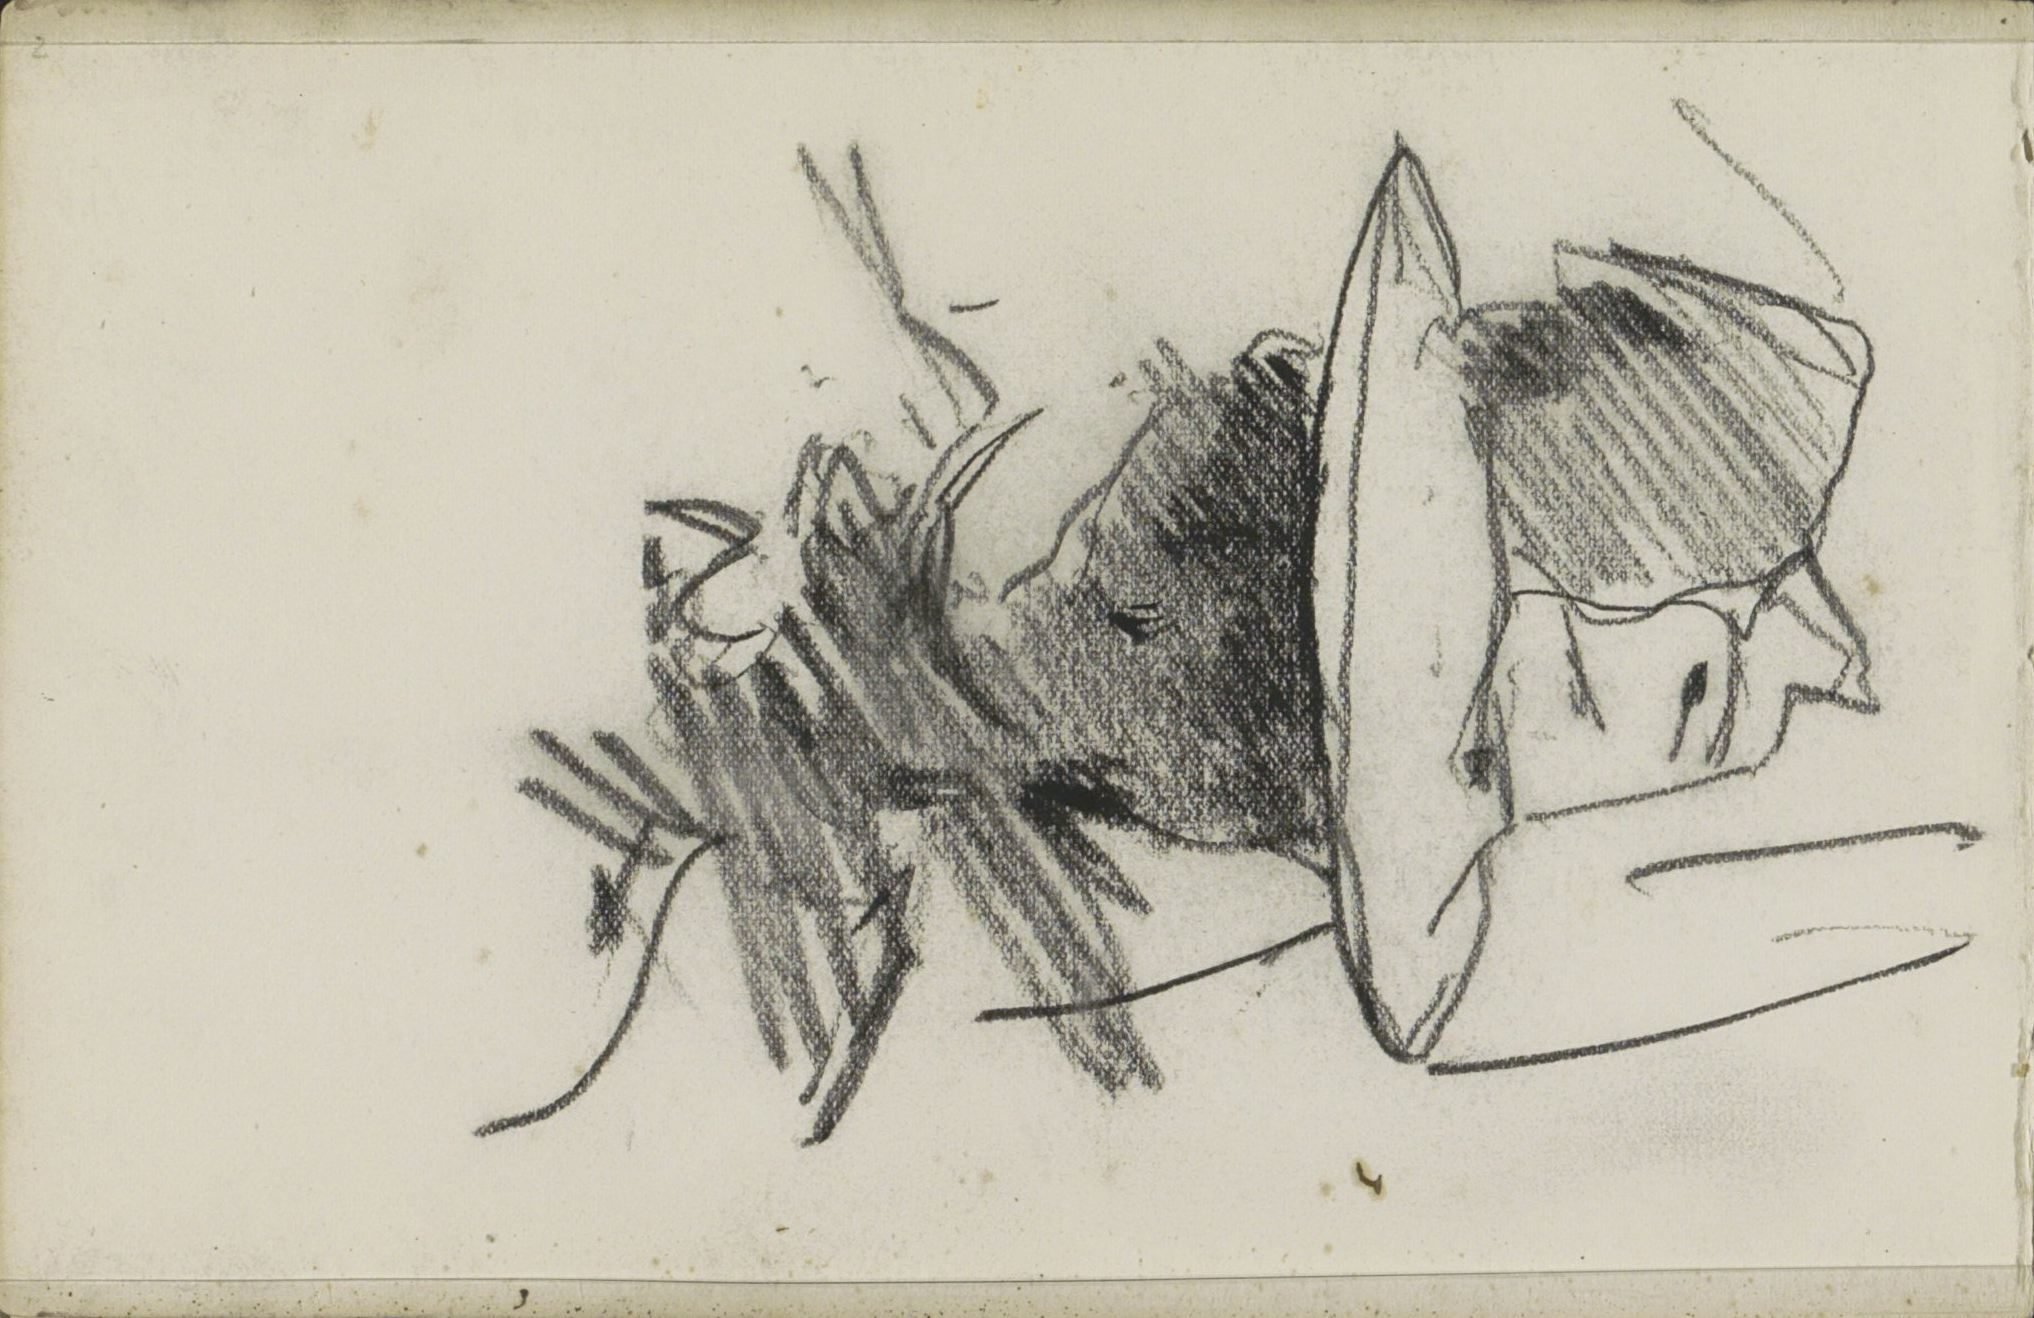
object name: sketchbook leaf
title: Buste van een vrouw met hoed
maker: willem witsen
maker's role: draughtsman, painter, print maker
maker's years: 1860-1923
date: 1888-1891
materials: chalk, paper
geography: london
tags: adult woman, head-gear: hat (+ women's clothes)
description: Pagina 2 uit een schetsboek met 19 bladen.